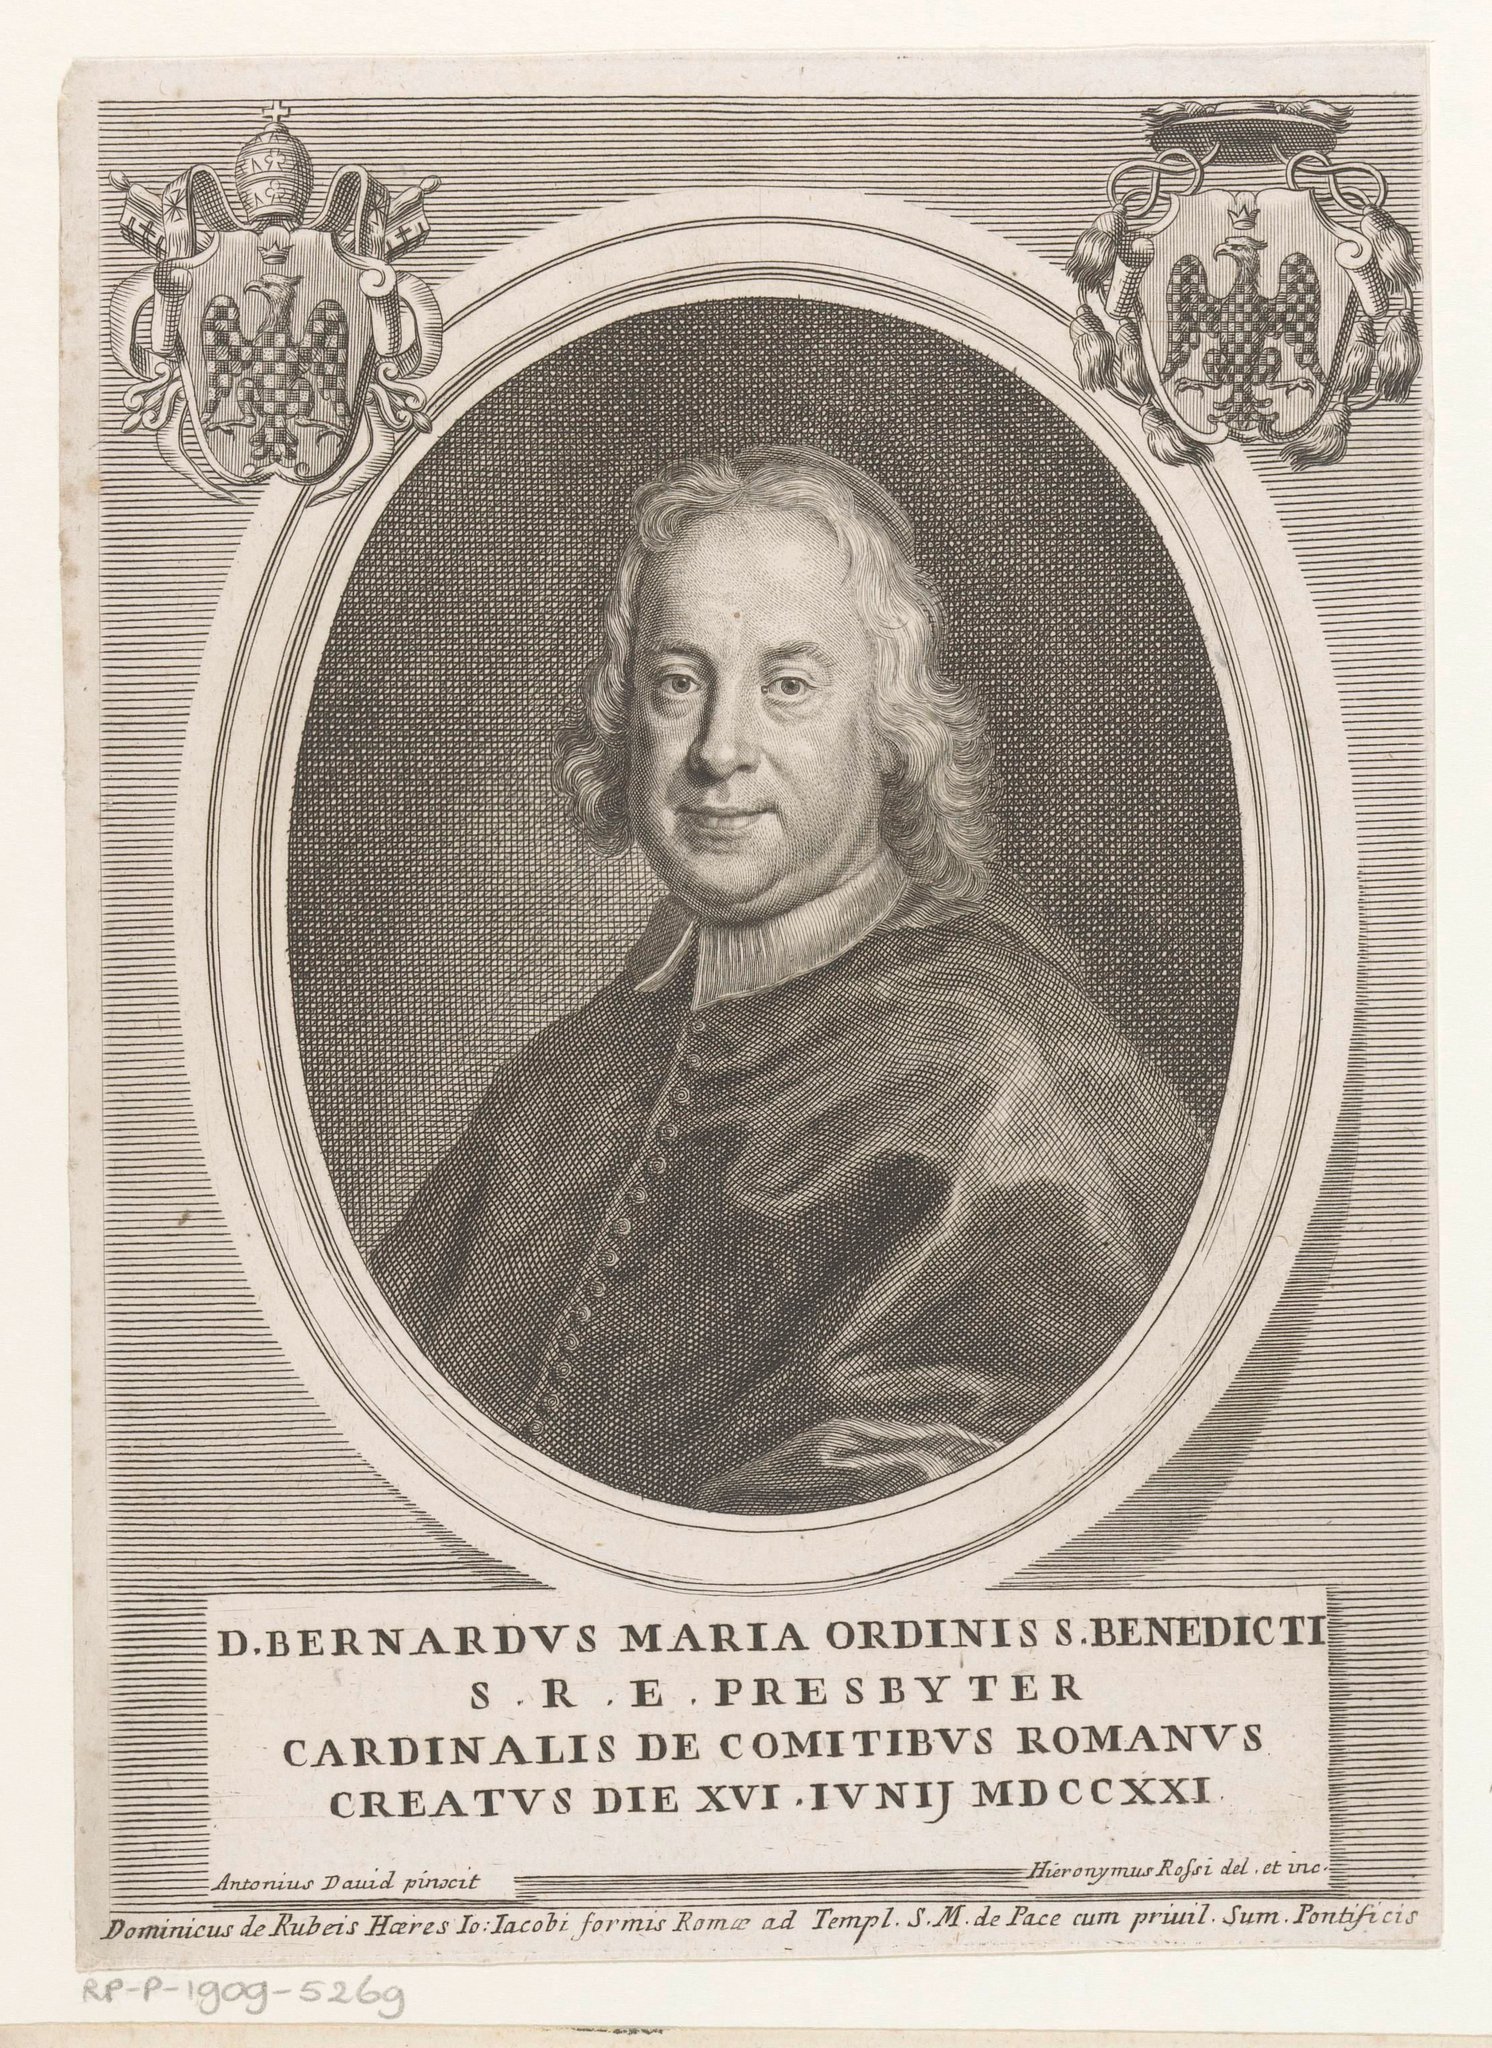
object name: print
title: Portret van kardinaal Bernardo Maria Conti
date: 1721-1762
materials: paper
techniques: engraving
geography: italy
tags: cardinal, historical persons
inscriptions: collector's mark: Lugt 2228